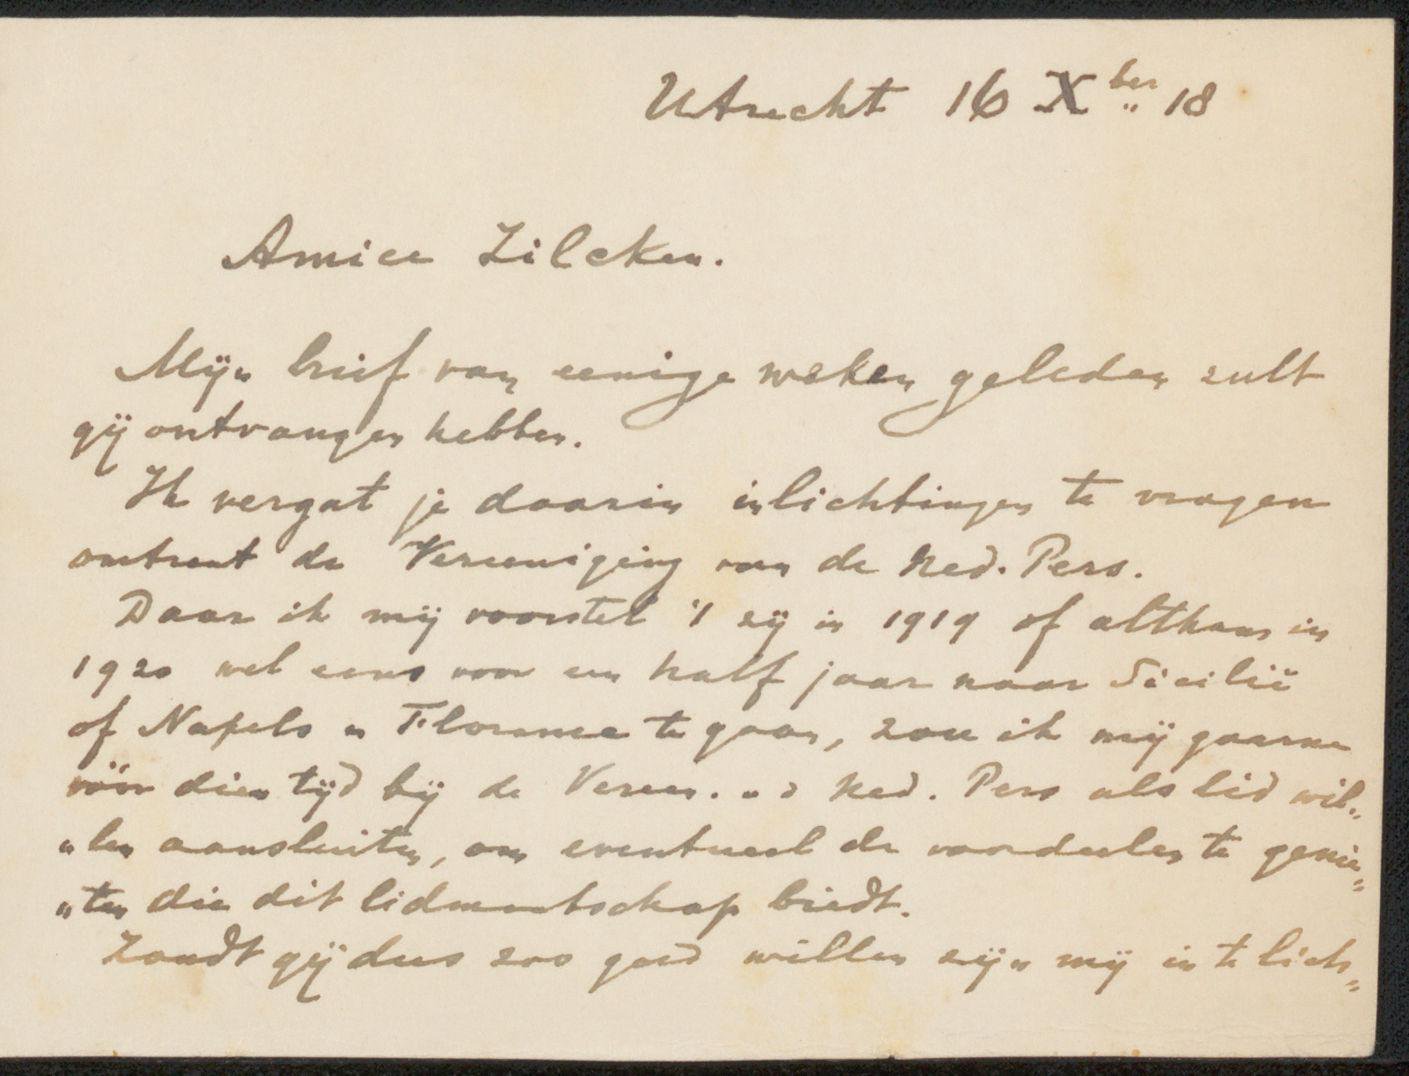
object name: letter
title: Brief aan Philip Zilcken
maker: n.j. singels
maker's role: leraar, schrijver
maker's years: 1857-1931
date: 1918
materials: cardboard, ink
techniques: pen, writing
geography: utrecht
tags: the hague, painter, draughtsman, philip zilcken, naples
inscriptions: collector's mark: ‘RPK’